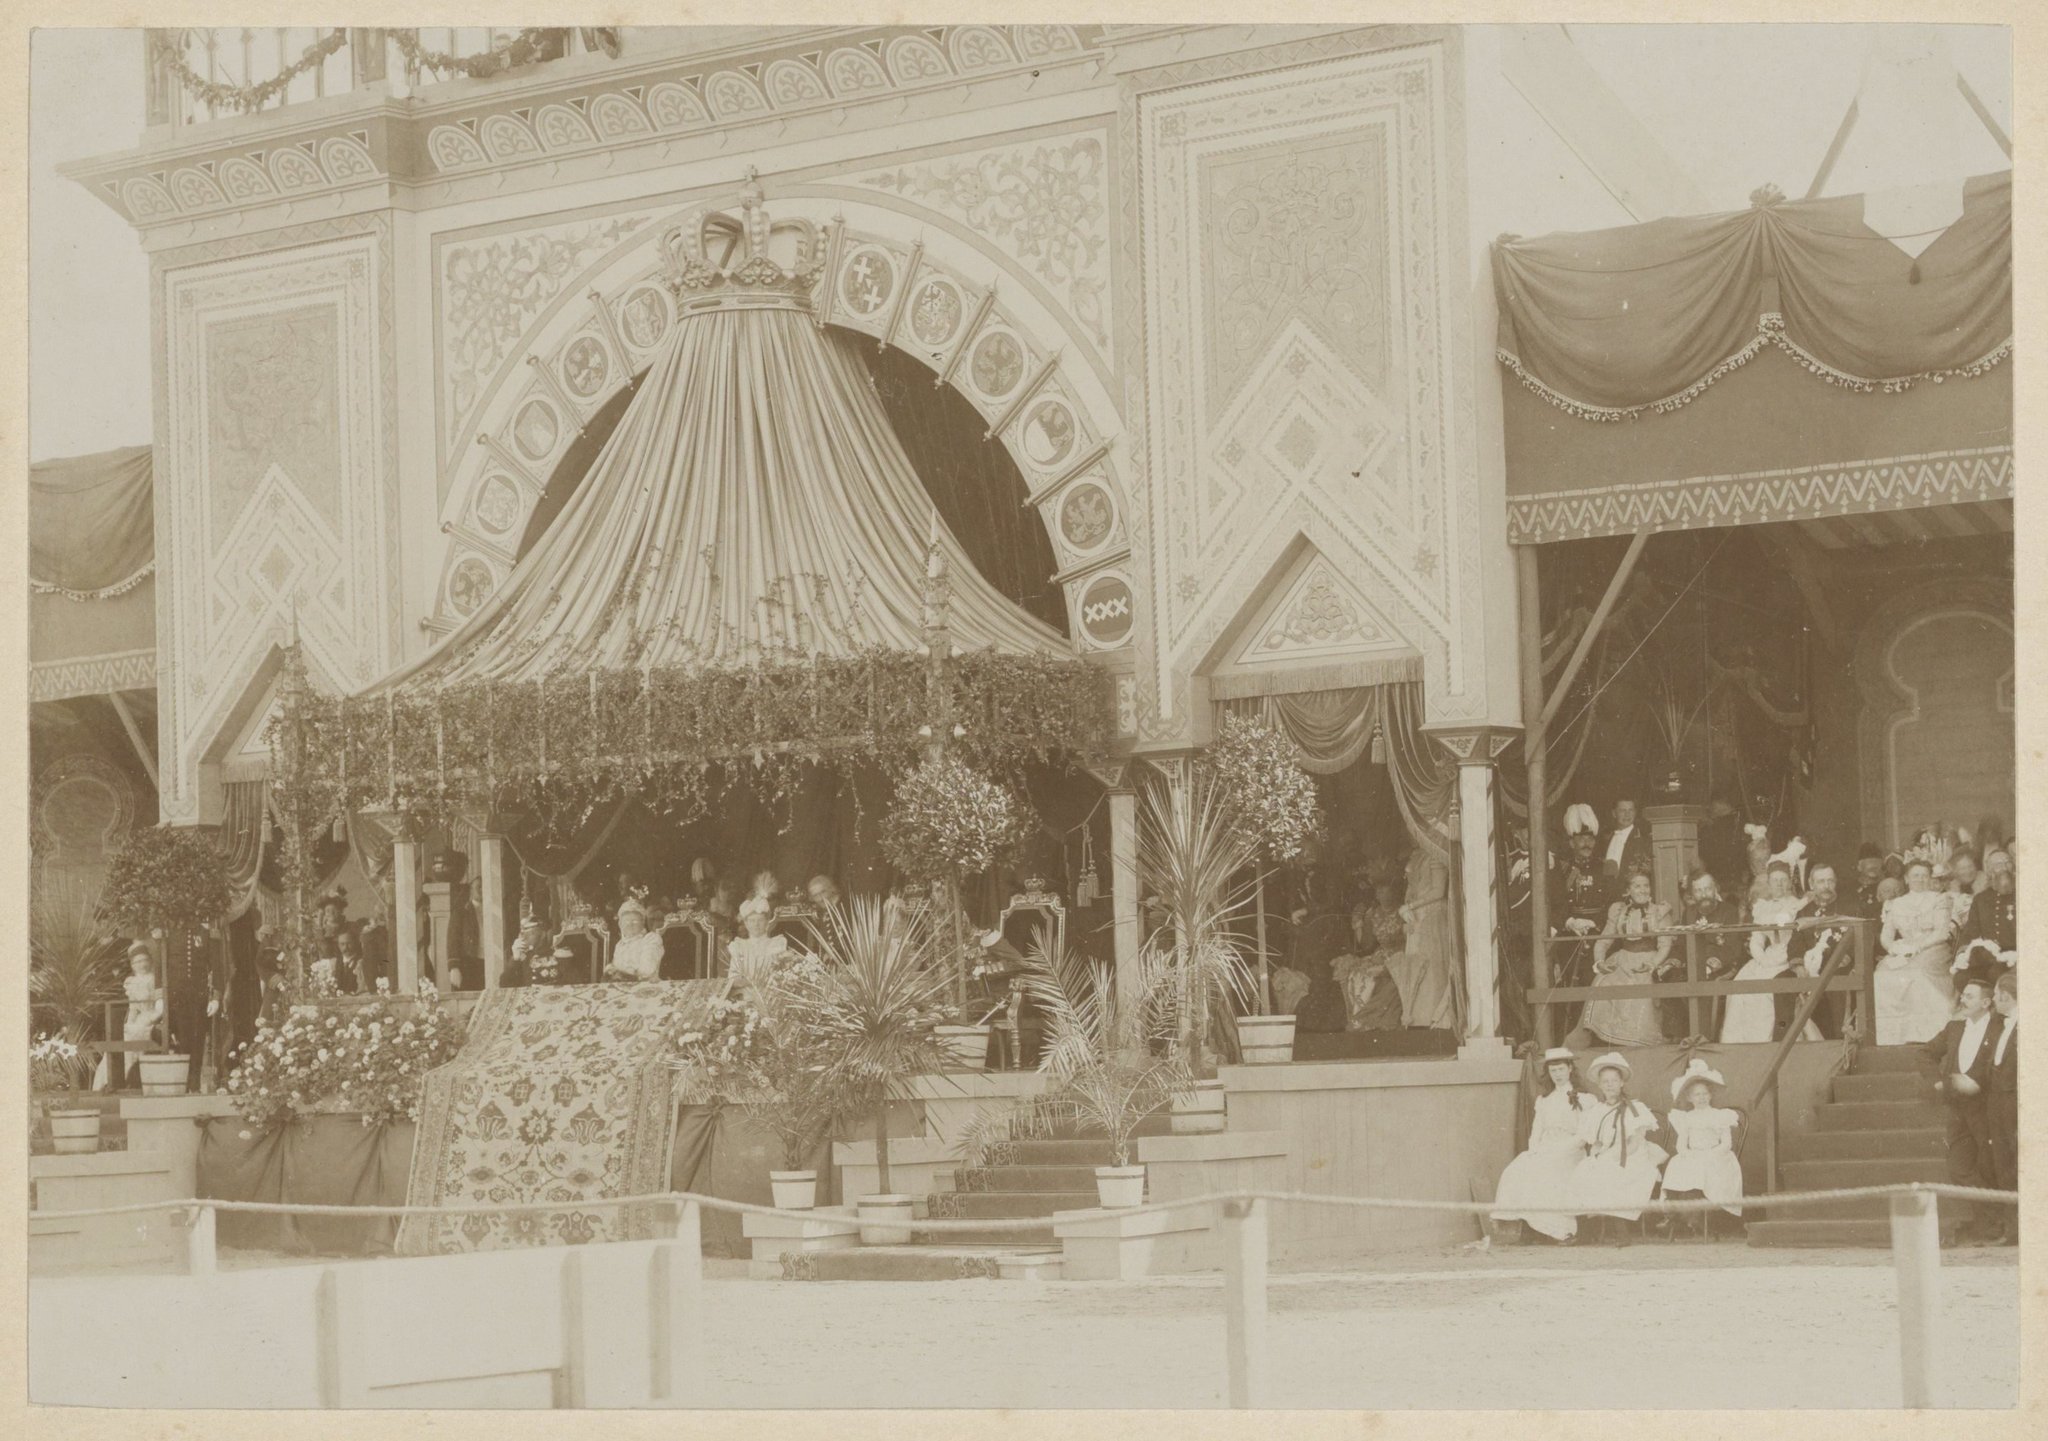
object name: photograph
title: Feestelijkheden op het terrein van de IJsclub te Amsterdam ter gelegenheid van de inhuldiging van Koningin Wilhelmina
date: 1809-1898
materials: cardboard, paper, photographic support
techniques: collodion silver print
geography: museumplein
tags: the hague, print maker, wilhelmina of the netherlands, emma (queen consort of the netherlands), ceremonial celebration of installation of a ruler, public festivities on the occasion of royal events, canopy, baldachin, installation of a ruler - bb - female ruler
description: Gezeten onder een baldakijn wonen Koningin-Moeder Emma, Prinses Wilhelmina en hoogwaardigheidsbekleders feestelijkheden bij op het terrein van de IJsclub (nu het Museumplein), aan de vooravond van de inhuldiging van de prinses. Onderdeel van Fotoalbum met 11 opnames van de inhuldiging van Koningin Wilhelmina en de inhuldigingsfeesten.